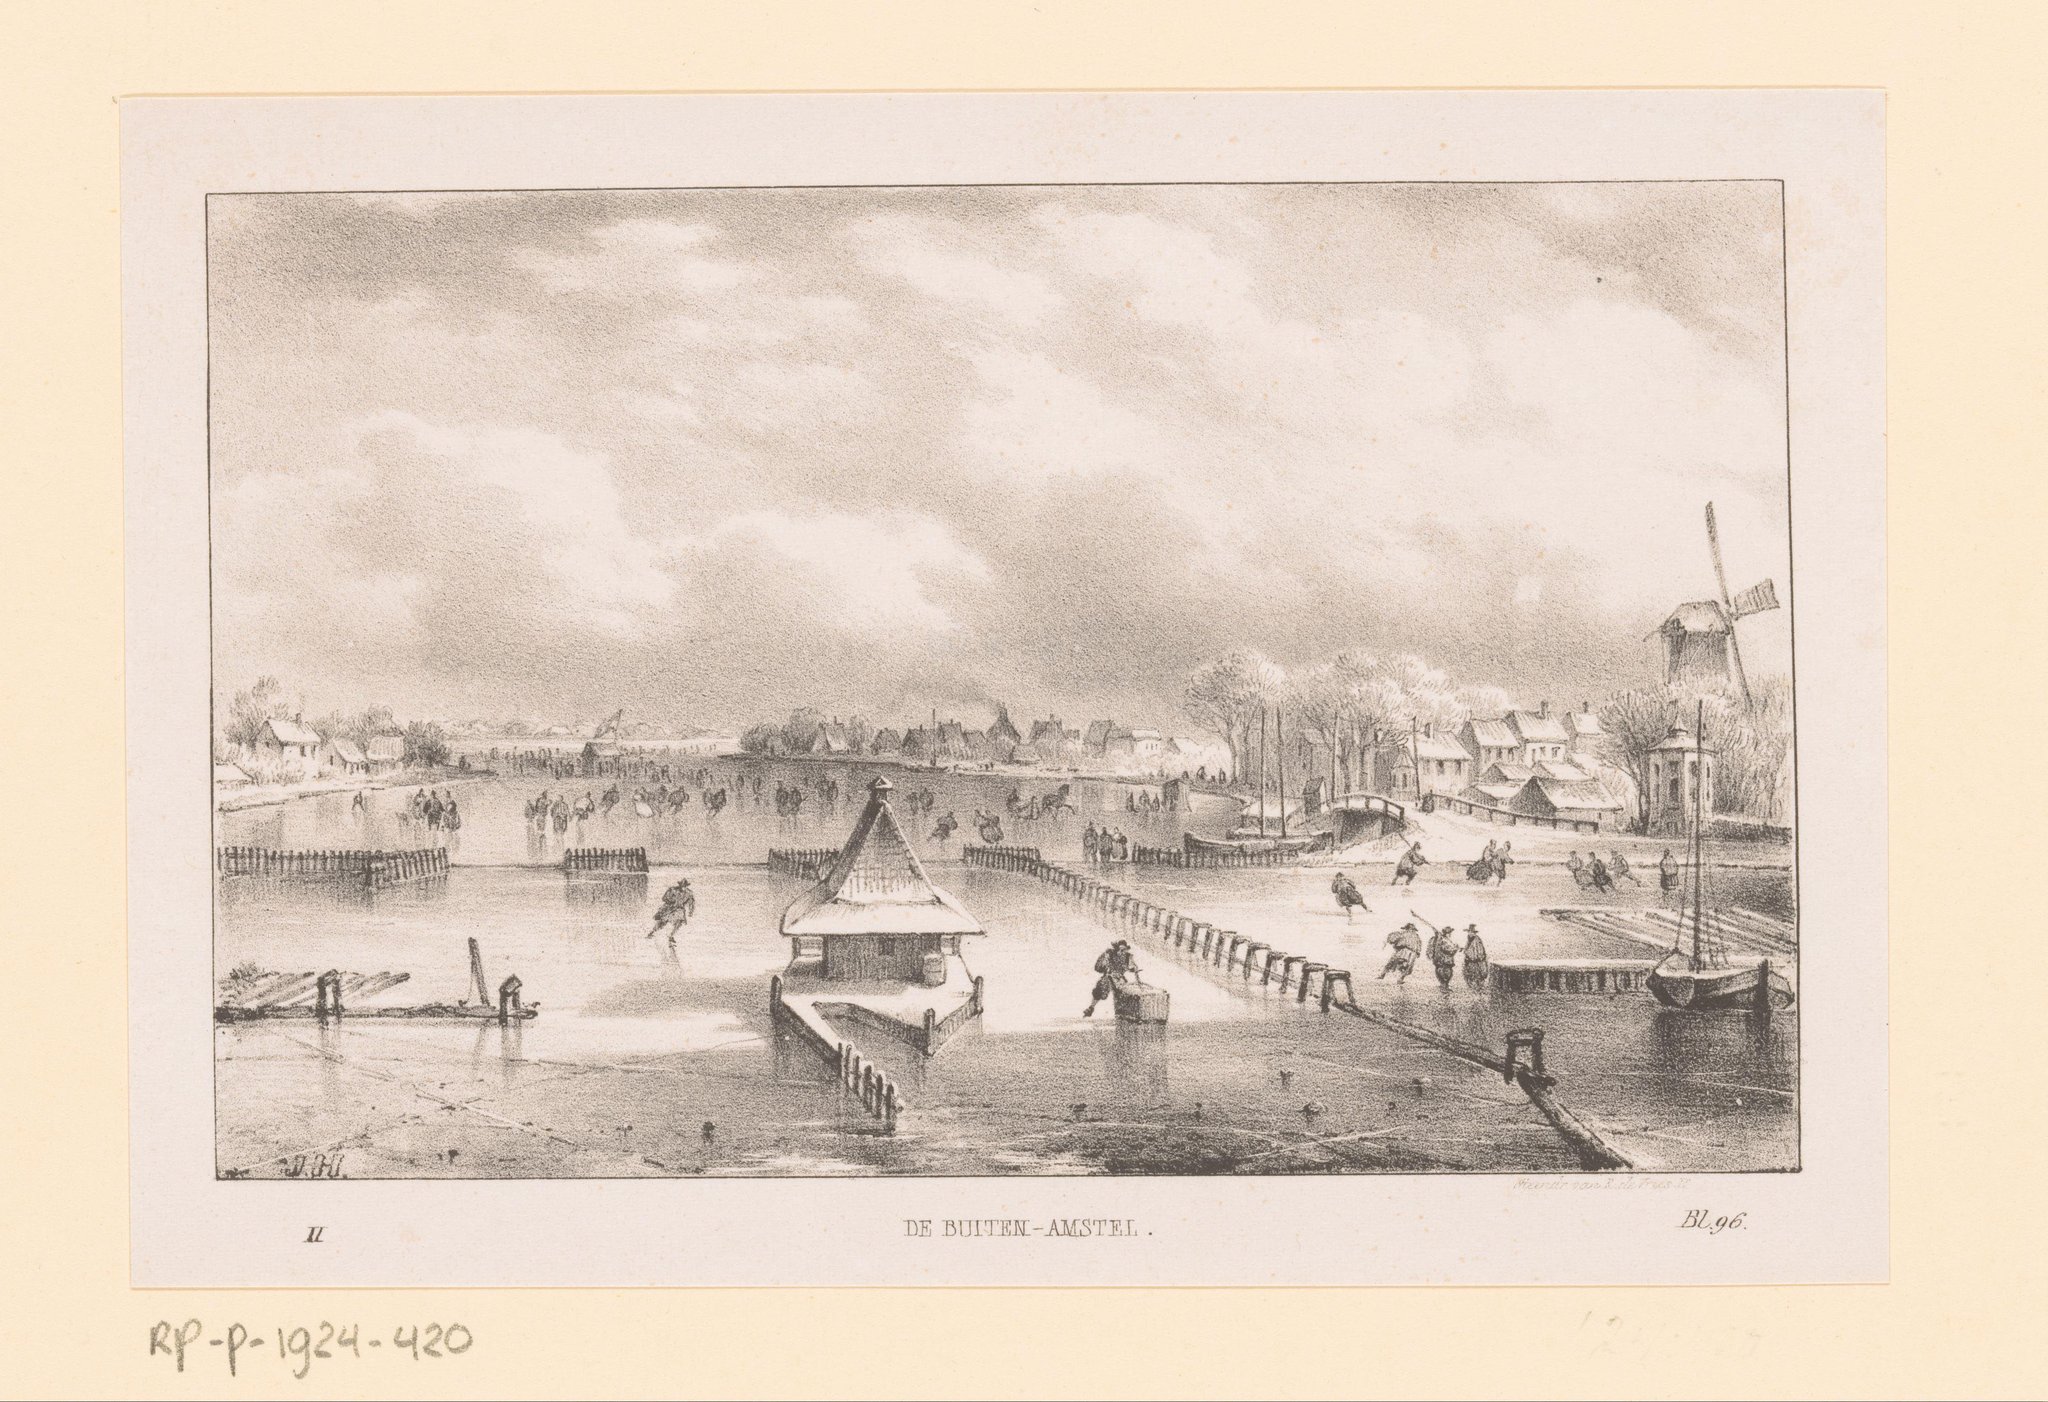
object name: print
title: De Buiten-Amstel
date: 1848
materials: paper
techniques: lithograph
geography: amsterdam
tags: skates (winter sports), river (+ landscape with figures, staffage)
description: Prent uit: Vijver, C. van der. Geschiedkundige beschrijving der stad Amsterdam. Amsterdam: Gebroeders Diederichs, 1848, dl. 2.